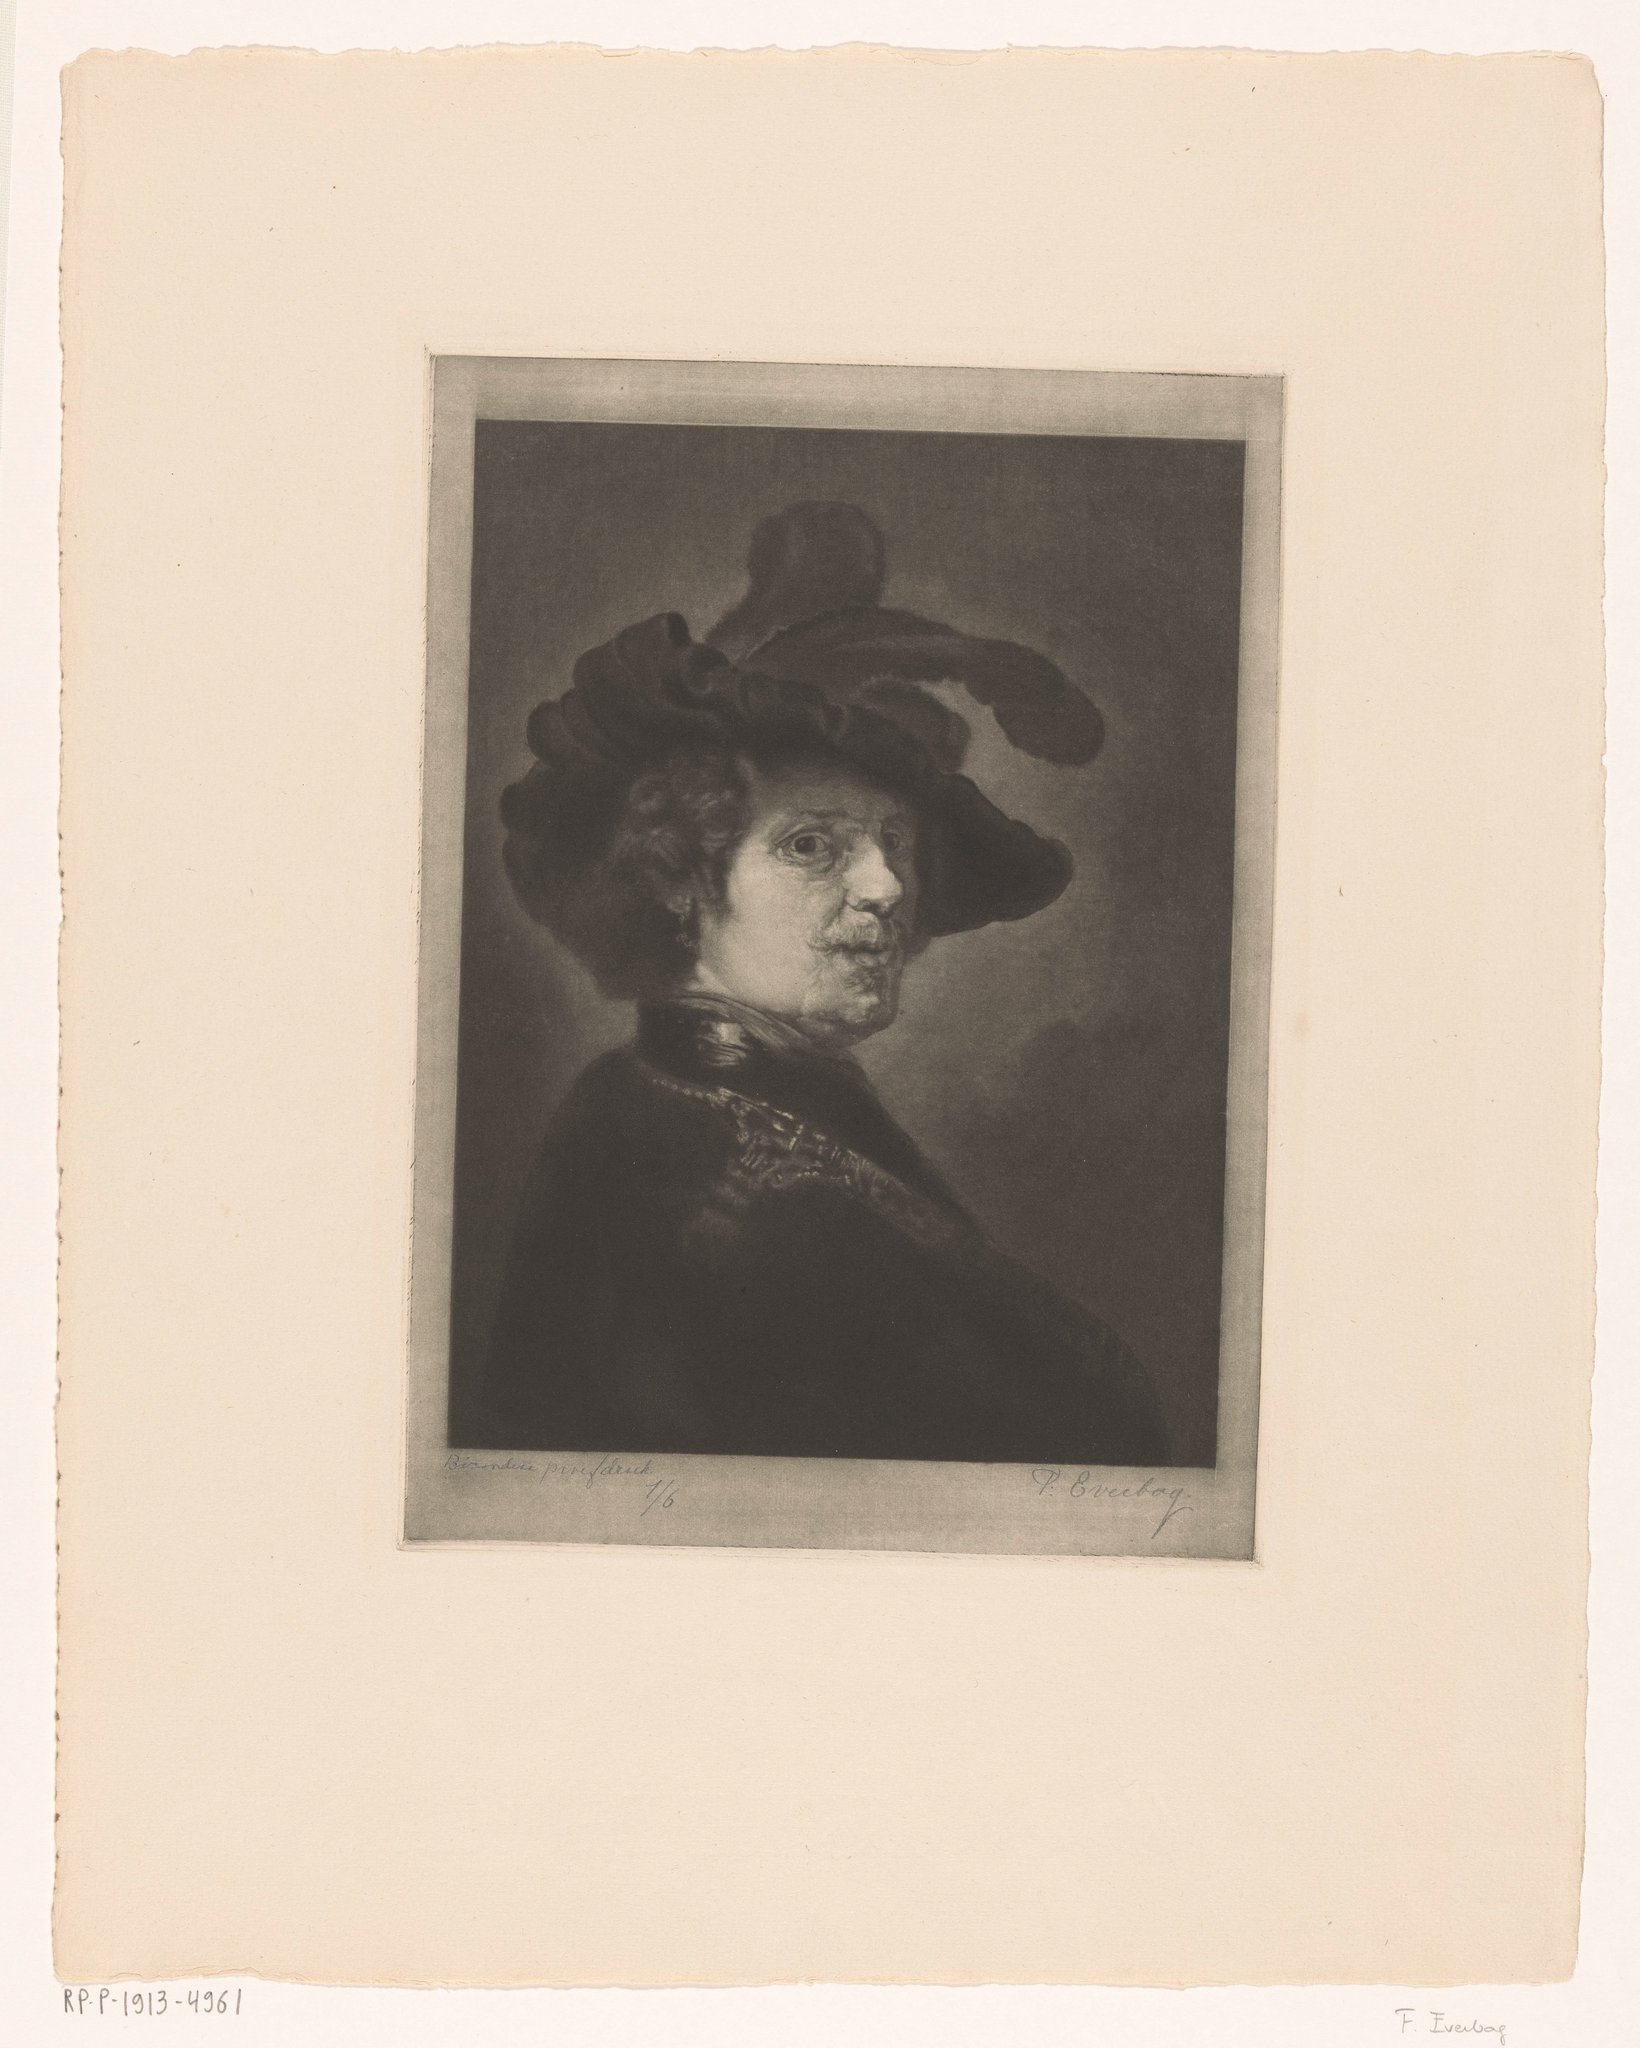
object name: print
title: Tronie van een man met gevederde baret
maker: frans everbag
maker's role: draughtsman, print maker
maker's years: 1877-1947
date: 1903-1913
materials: paper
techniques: mezzotint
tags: head-gear: beret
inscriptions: collector's mark: Lugt 2233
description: Een soldaat gekleed in een mantel en een baret met veren.